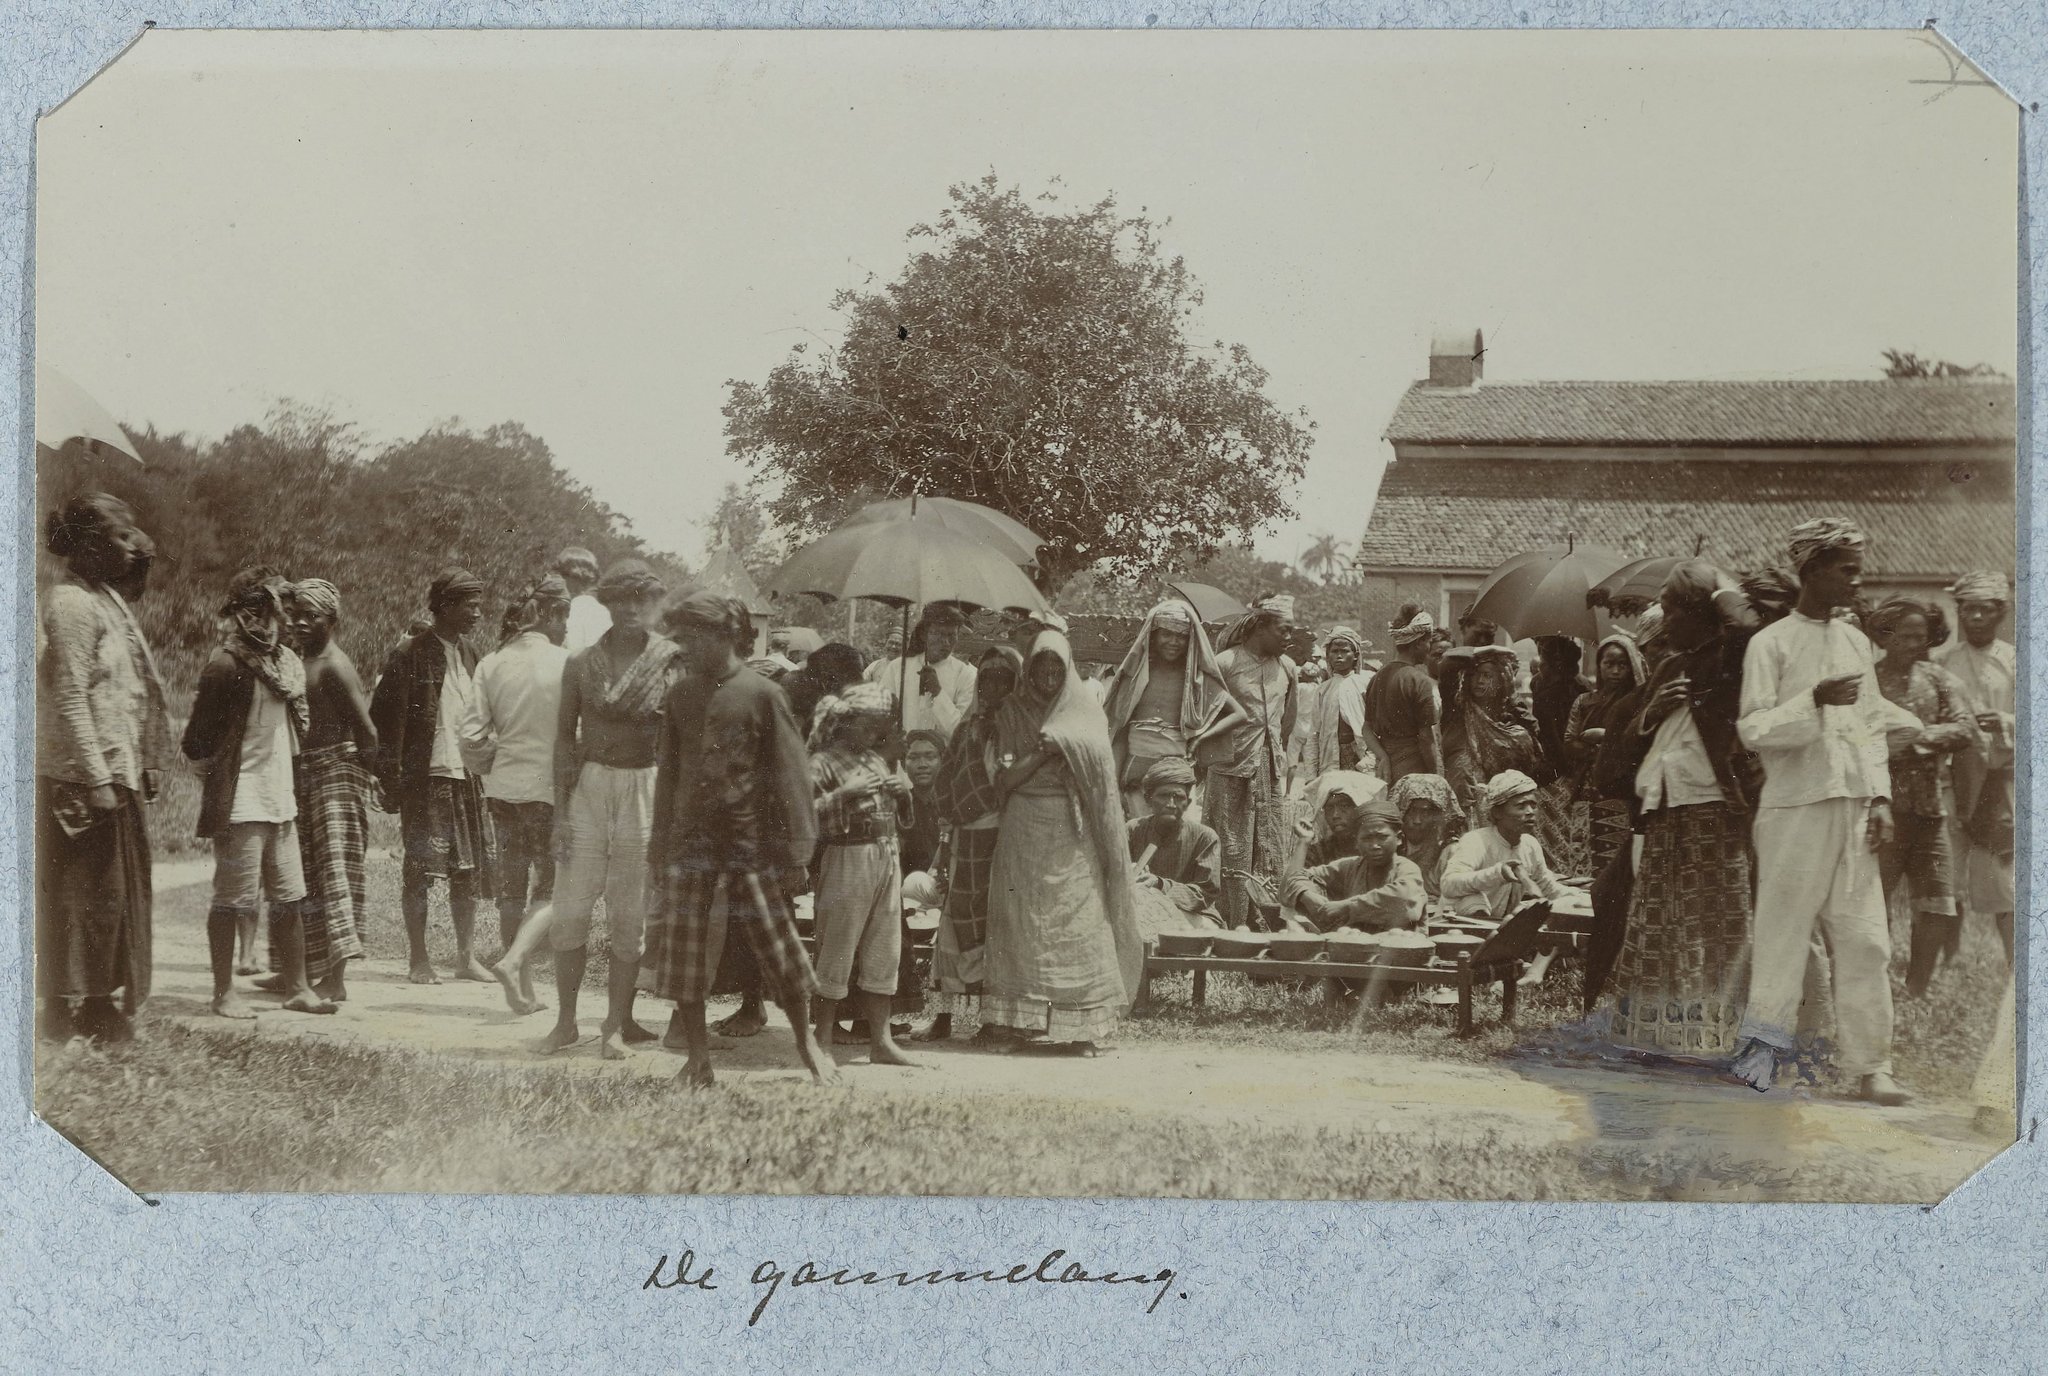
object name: photograph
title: De gammelang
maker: théodore van lelyveld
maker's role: painter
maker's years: 1867-1954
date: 1895-1898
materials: photographic support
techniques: collodion silver print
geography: suriname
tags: small group of musicians, chamber orchestra, jazz band, migrants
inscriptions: inscription: ‘De gammelang’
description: Een gamelan orkest in het immigrantendepot of zgn. ‘koeliedepot’, het centrale meldpunt voor immigranten in Paramaribo. Fotoafdruk in een fotoalbum van Théodore van Lelyveld over Suriname uit 1895-1898.